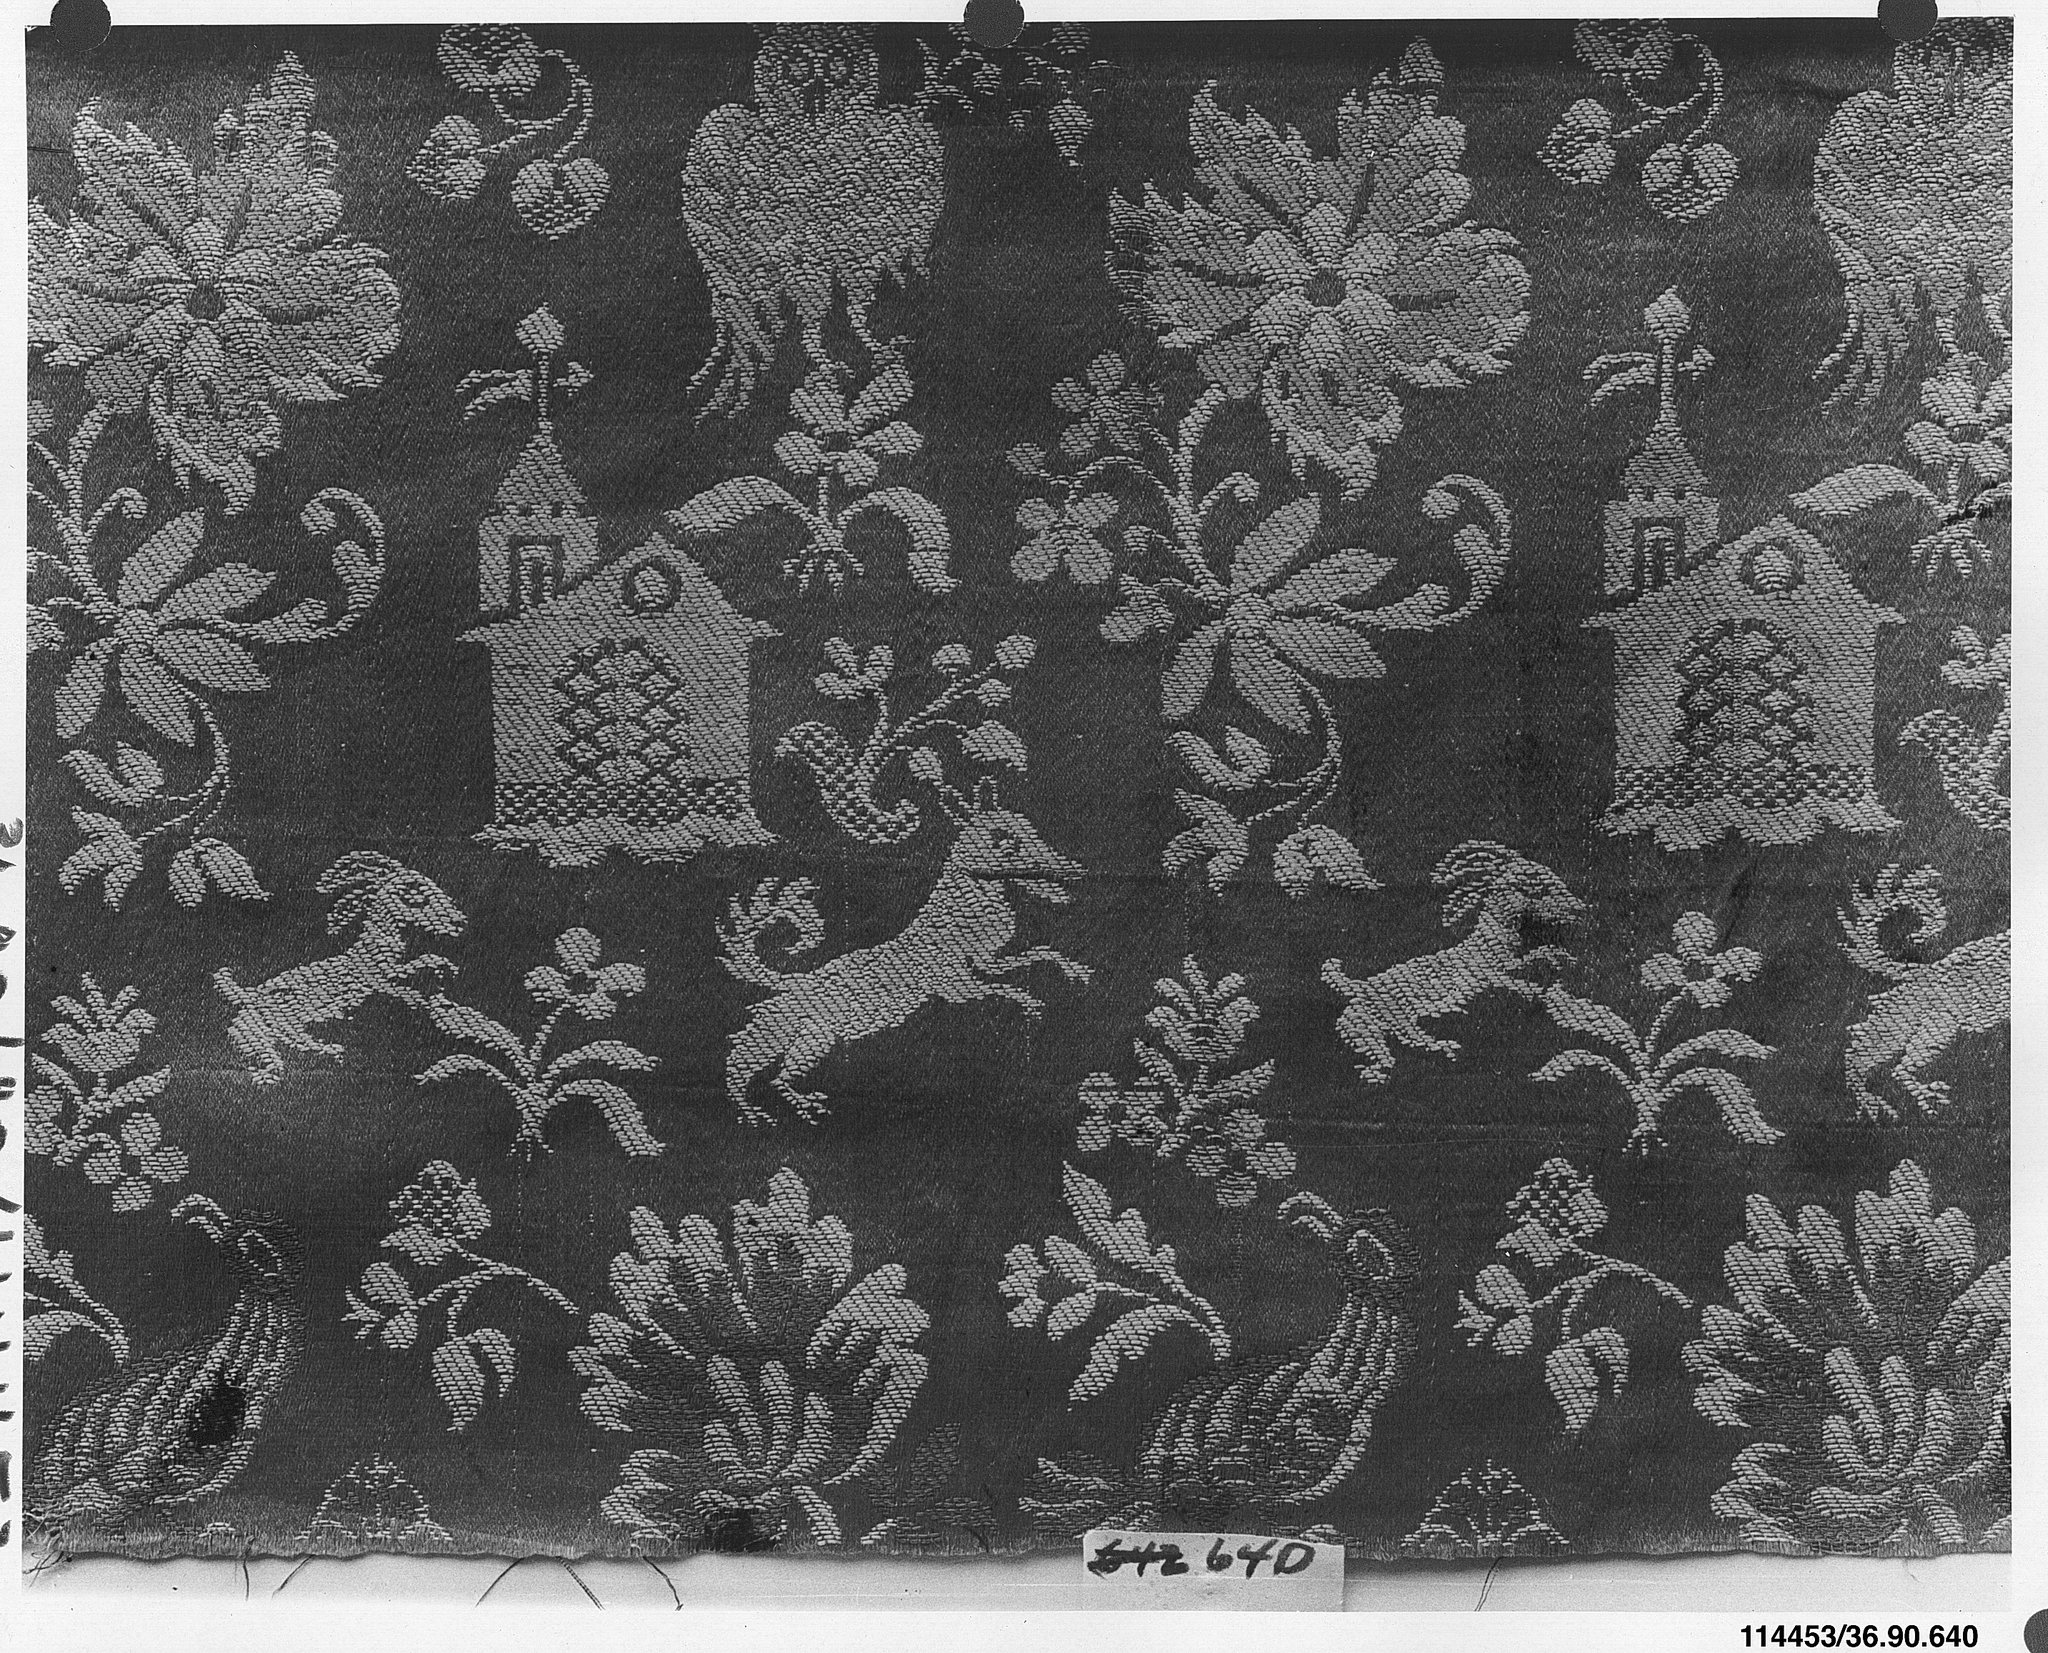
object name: piece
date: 1700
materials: silk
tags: animals,owls,flowers